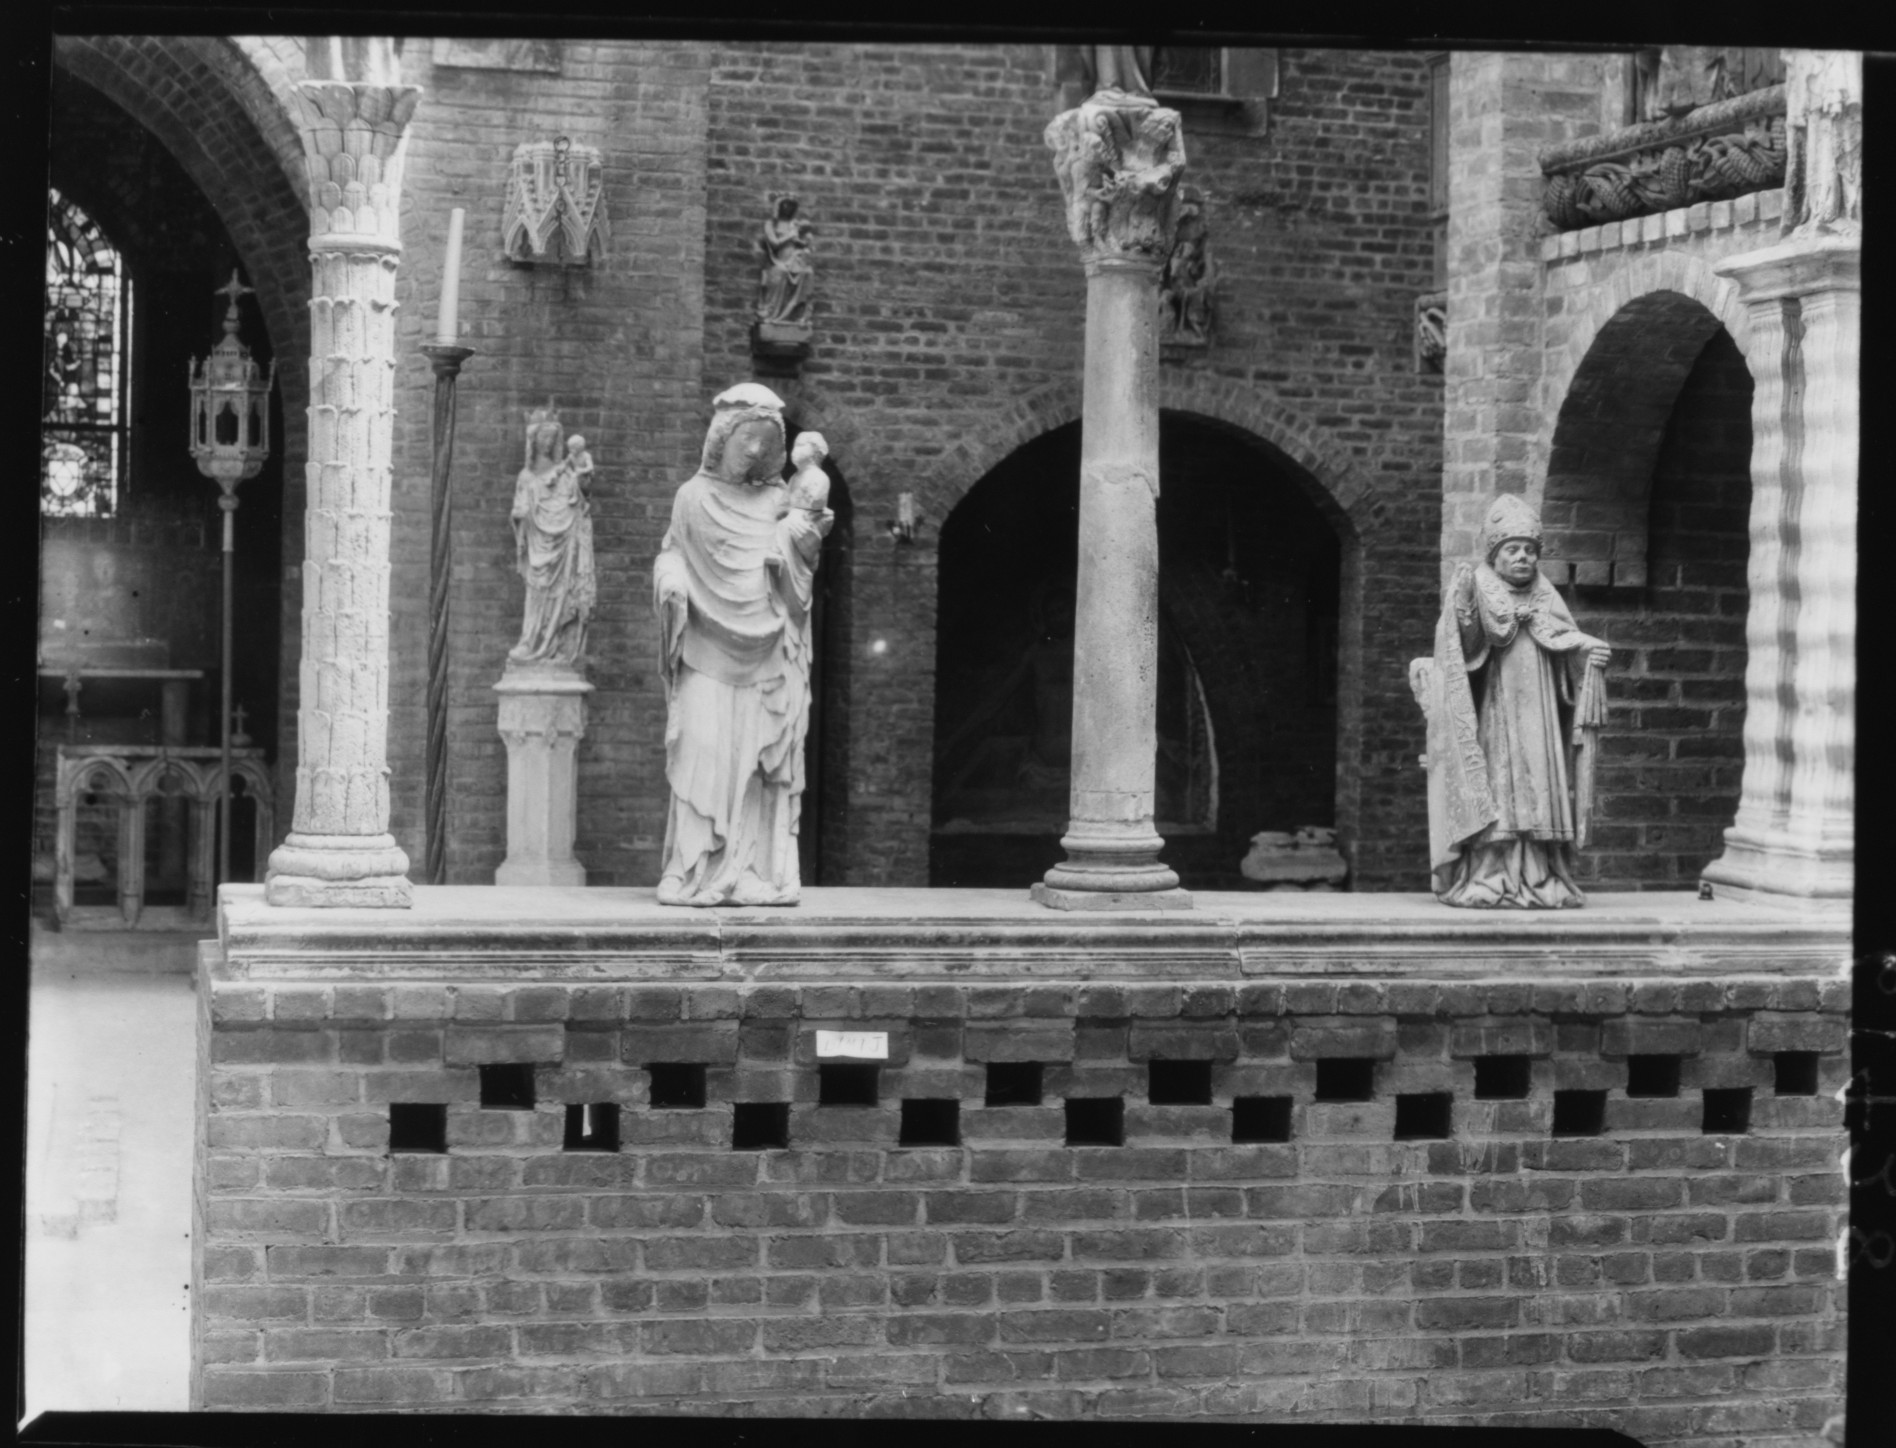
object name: slab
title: Coping Slabs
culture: french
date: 1101-1300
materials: stone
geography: france